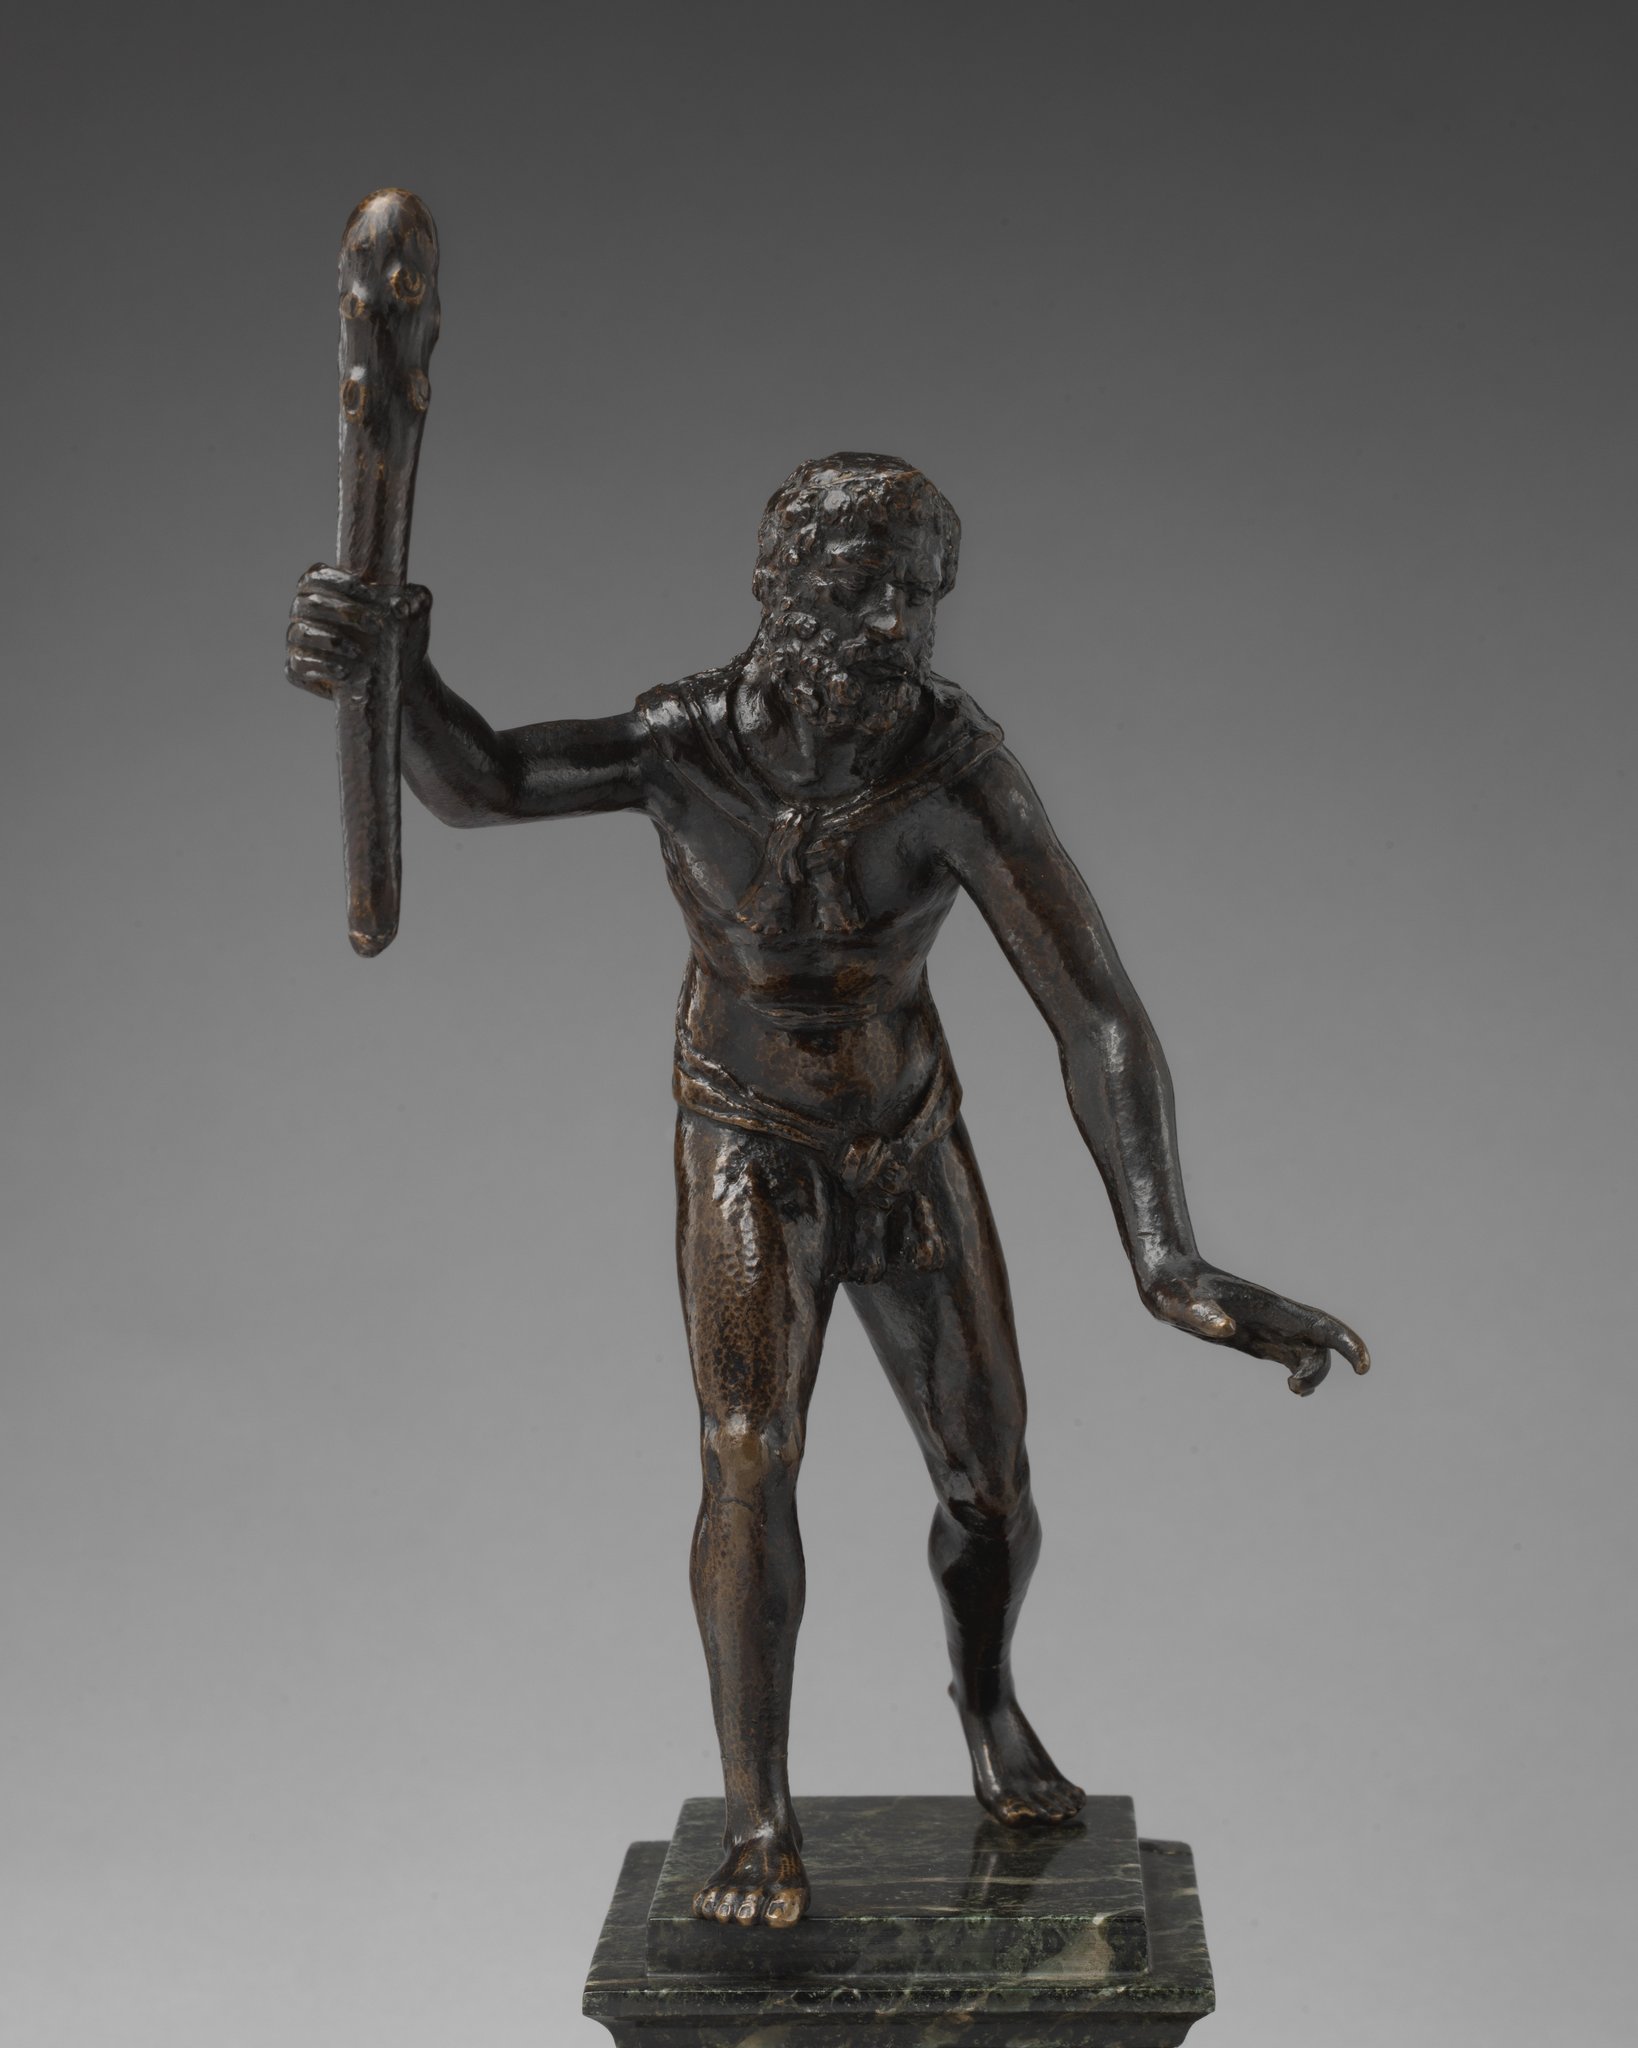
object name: statuette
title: Hercules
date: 1534-1566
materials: bronze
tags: hercules